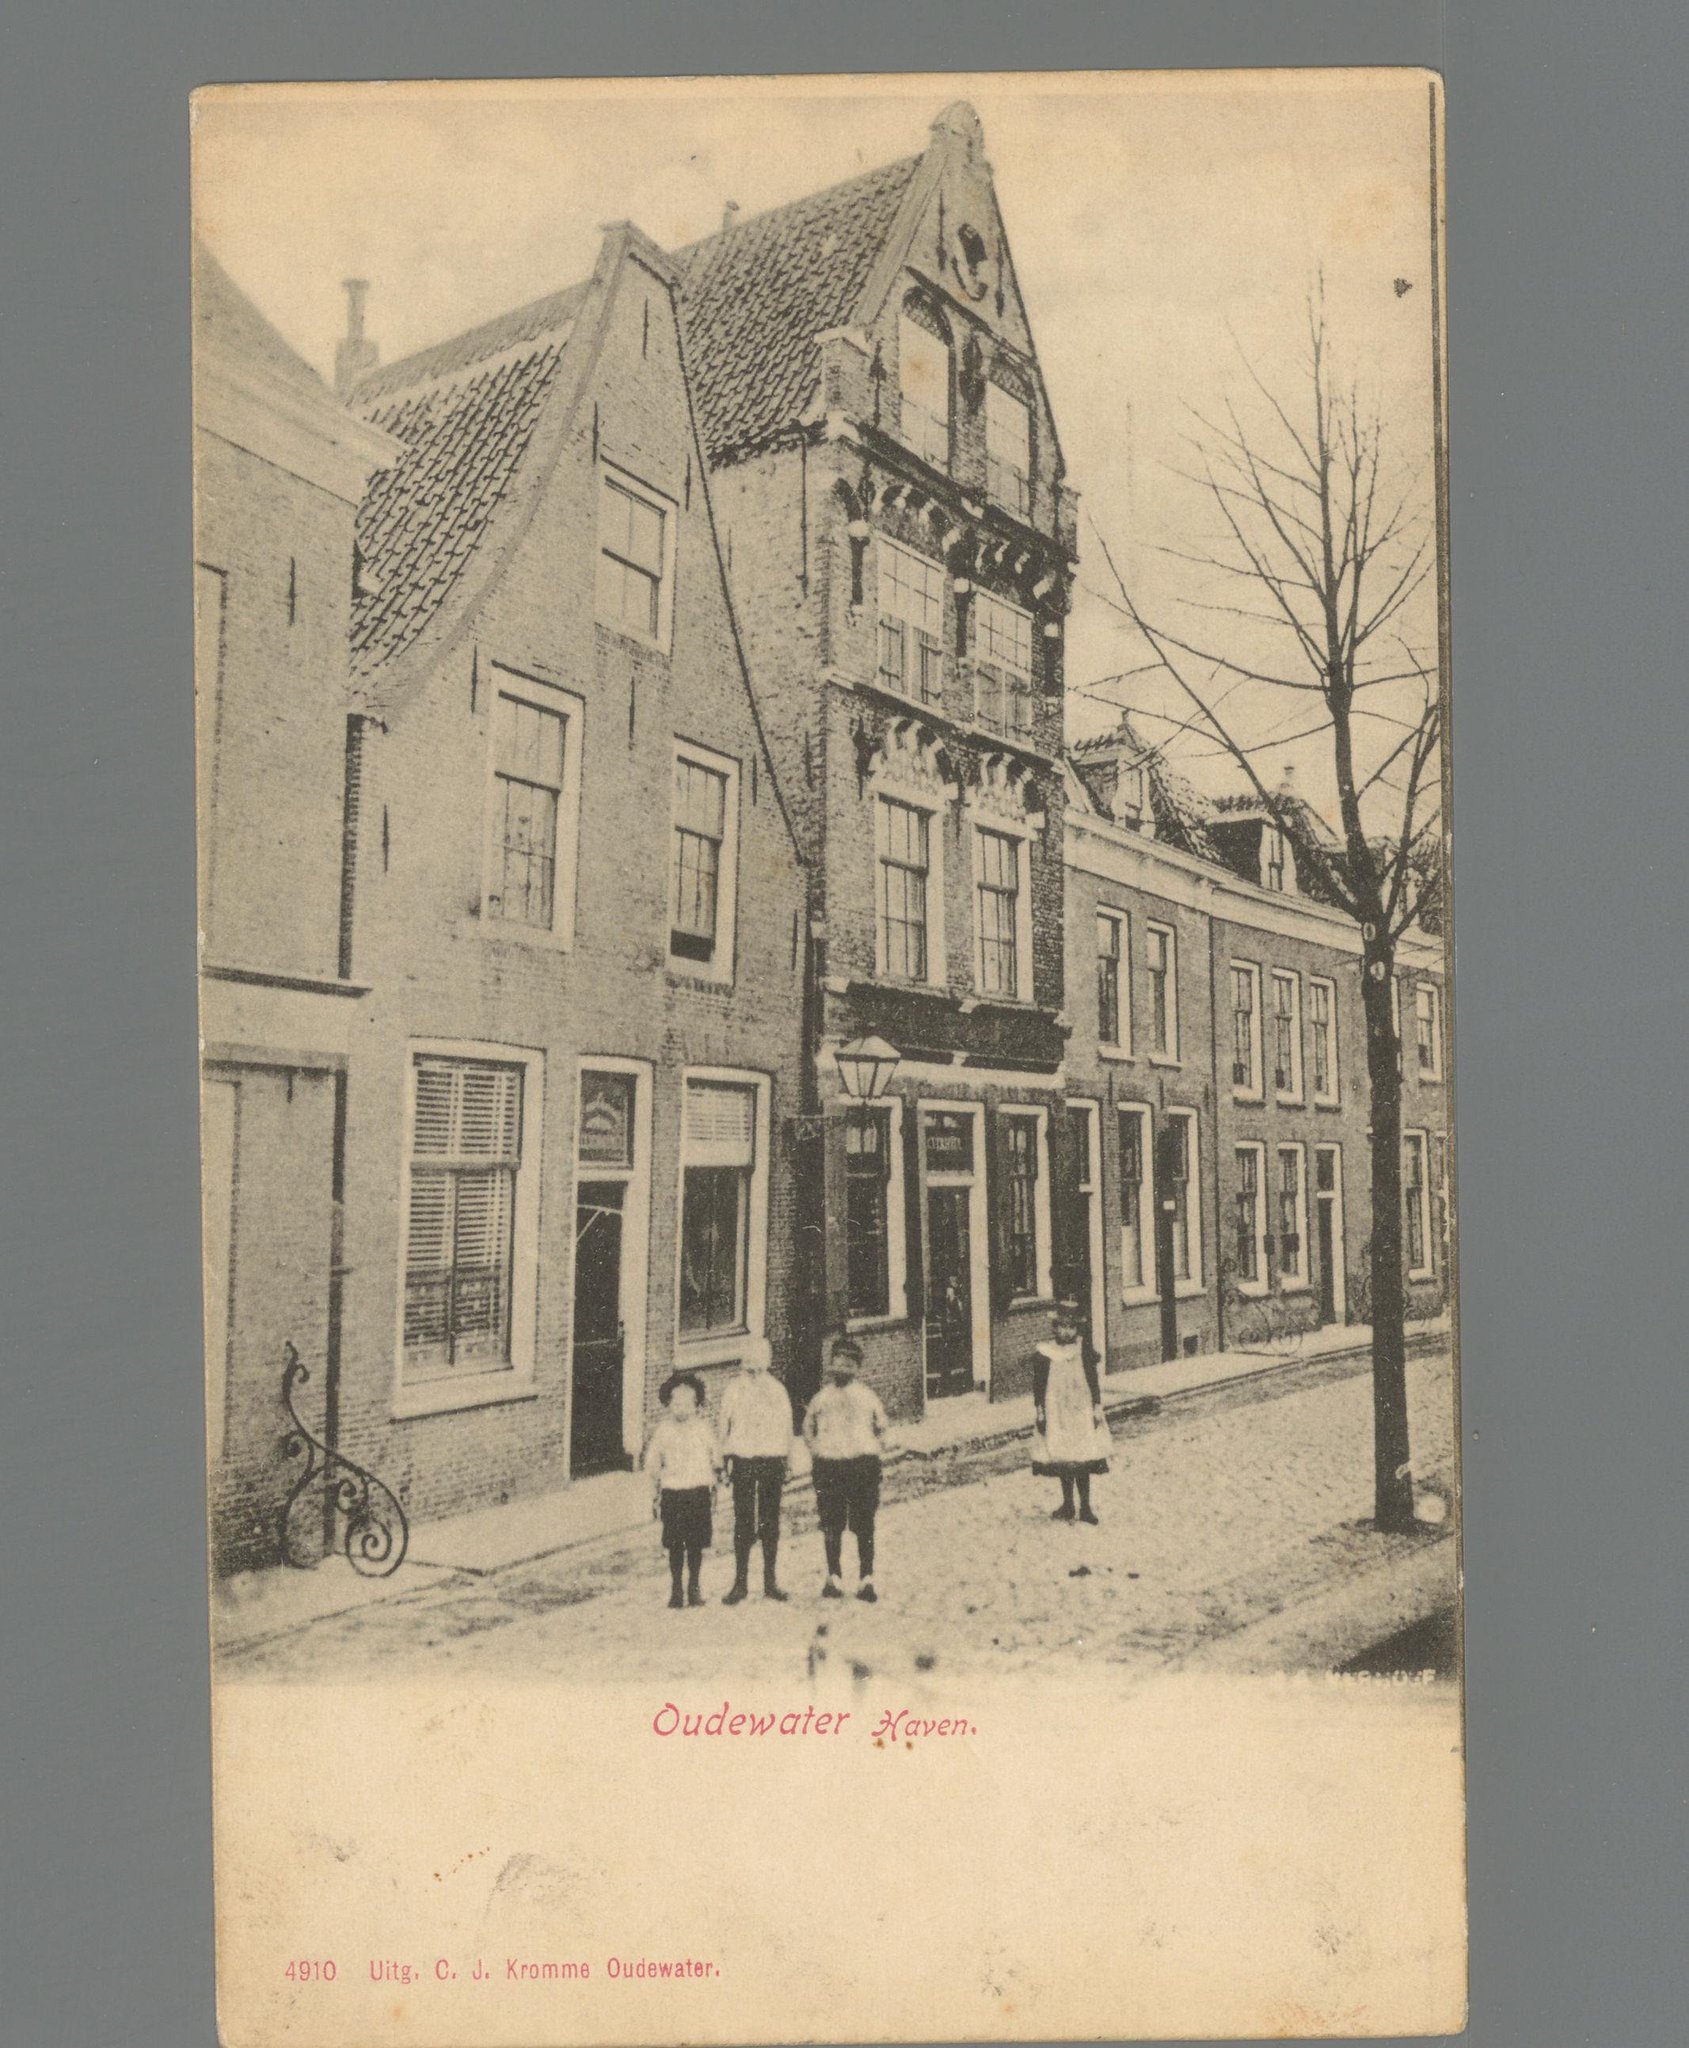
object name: ansichtkaart, prentbriefkaart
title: Oudewater. Haven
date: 1899-1905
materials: cardboard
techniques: photograph, writing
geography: oudewater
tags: street